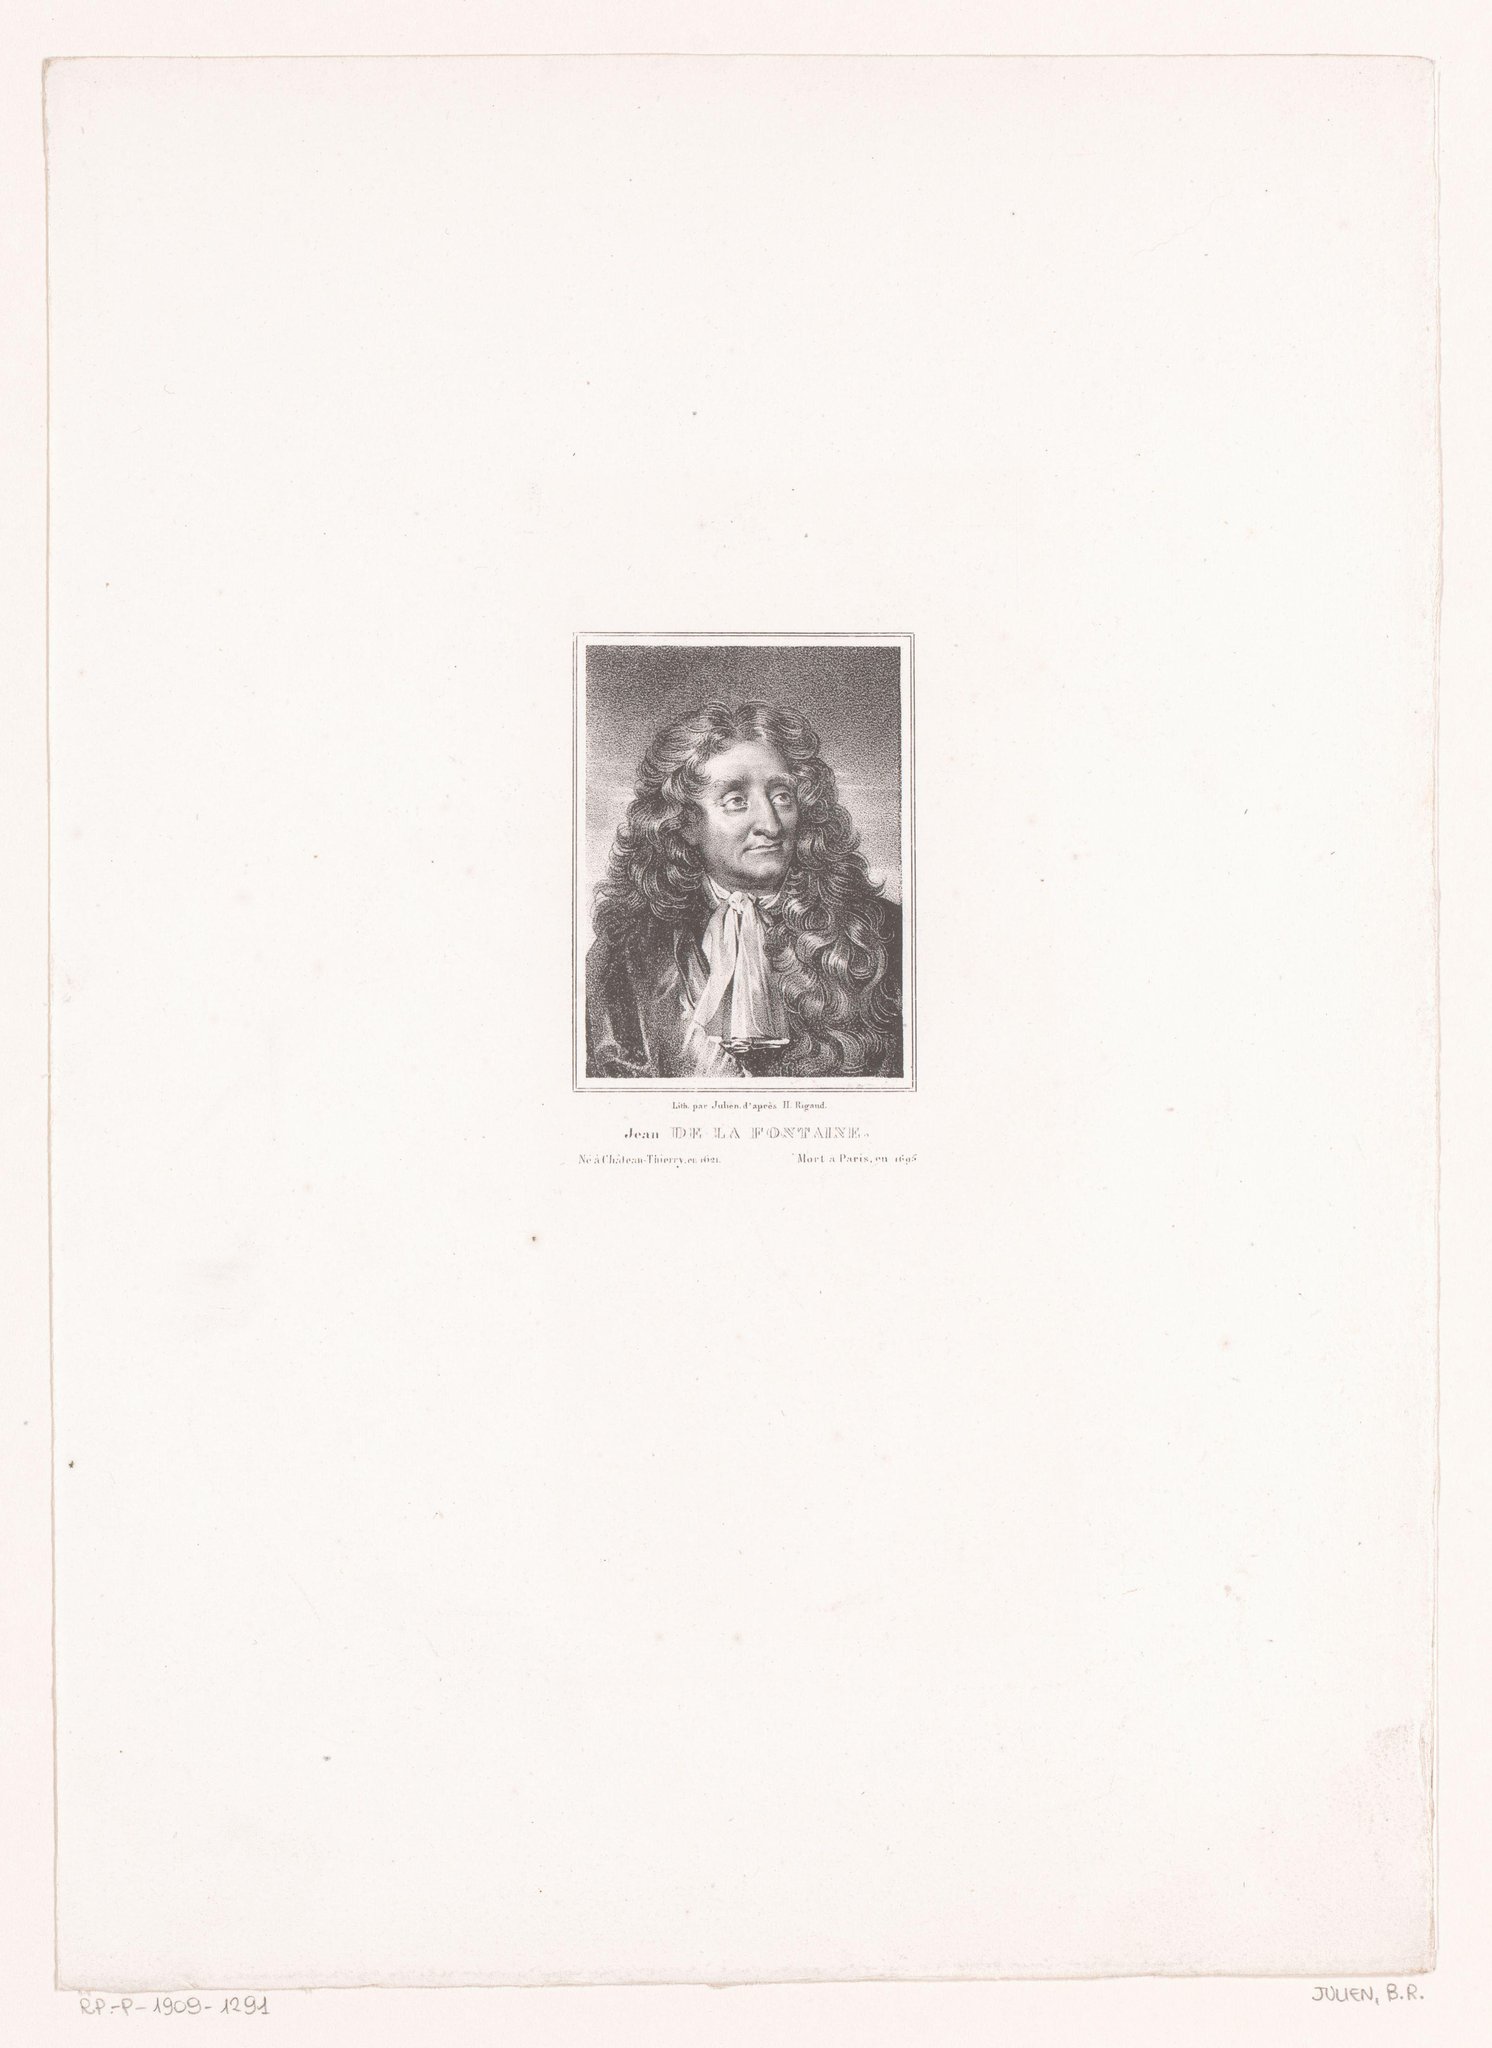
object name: print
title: Jean de la Fontaine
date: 1830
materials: paper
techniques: lithograph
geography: paris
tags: paris, jean de la fontaine, historical persons, portrait of a writer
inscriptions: collector's mark: Lugt 2228a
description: Prent gebruikt voor: Illustrations du Cours de Littérature de la Harpe, ou collection de 400 portraits destinés à l'ornement de cet ouvrage. Parijs: Boblet, 1830.